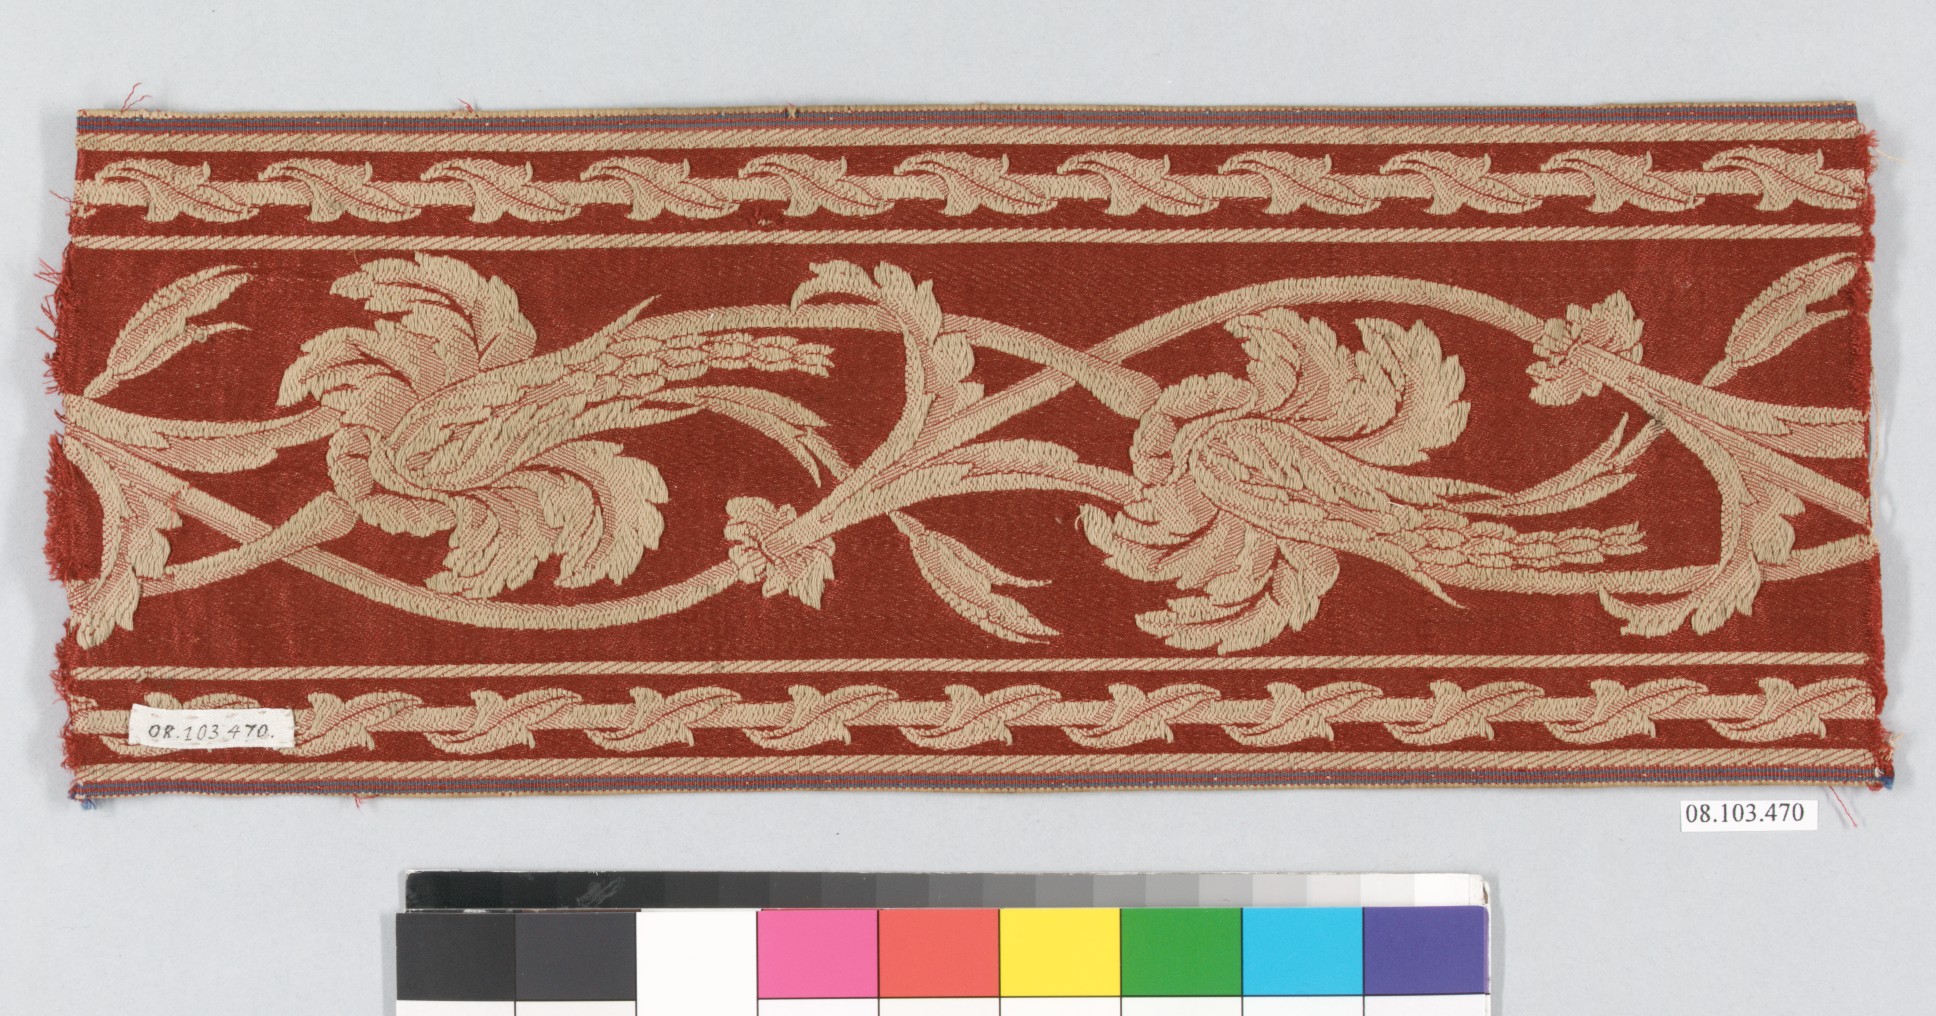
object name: ribbon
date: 1834-1866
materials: silk